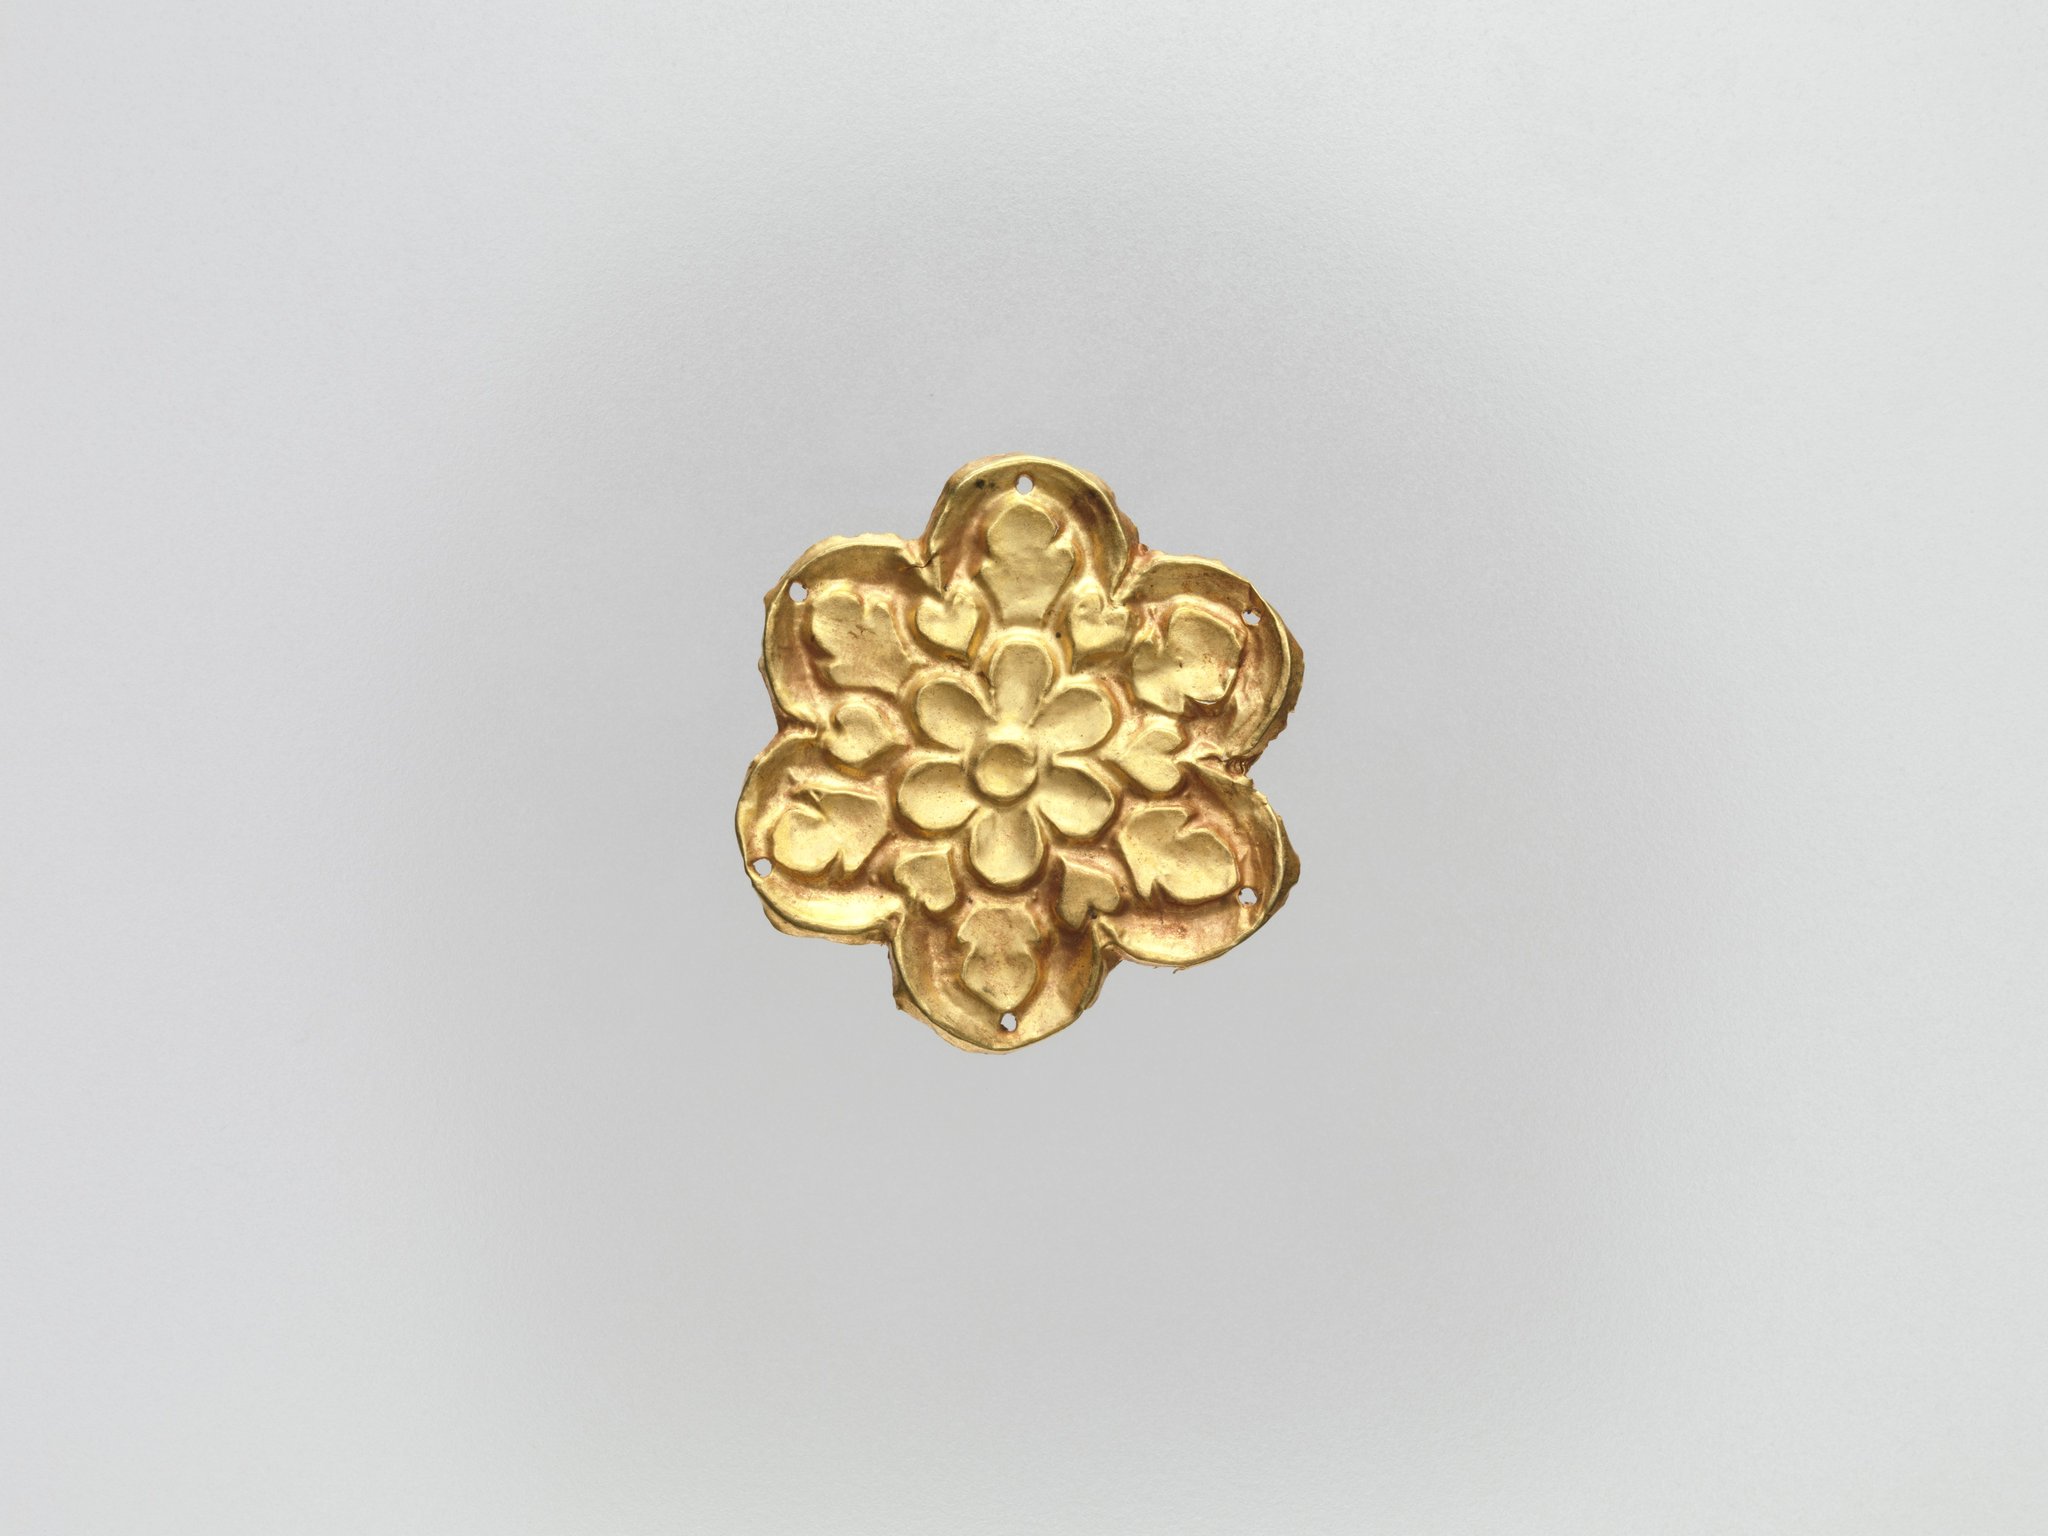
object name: garment plaque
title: Flower-Shaped Clothing Plaque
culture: chinese or central asian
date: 601-900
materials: gold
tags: flowers